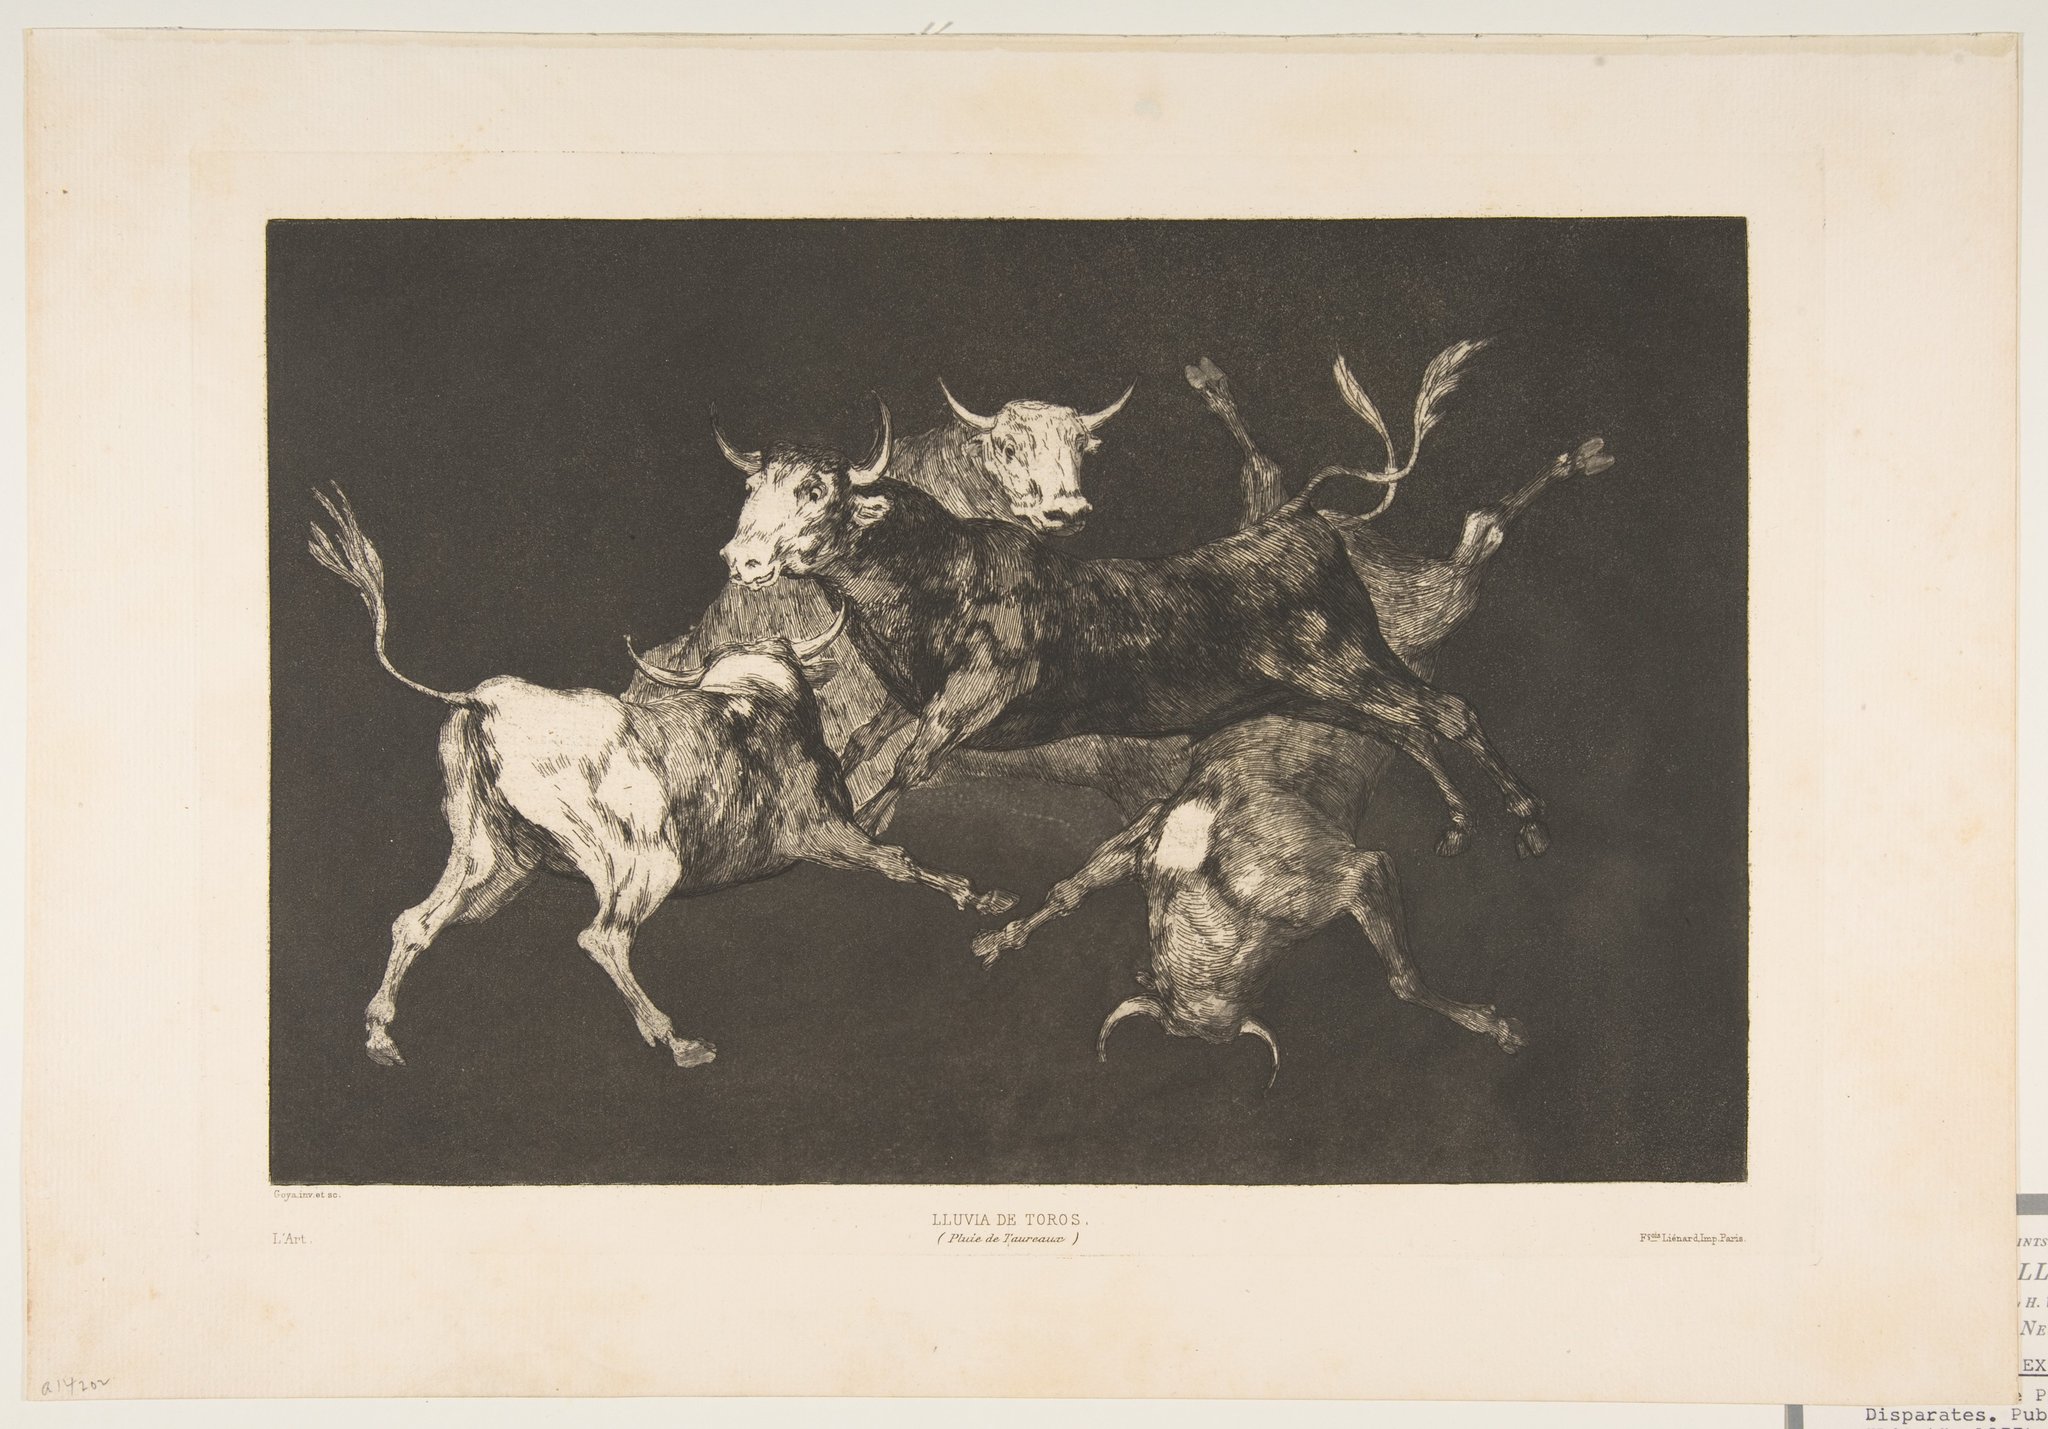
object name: print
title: Little Bulls' Folly, from "The Disparates" (Disparates, Plate D)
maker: goya (francisco de goya y lucientes)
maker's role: artist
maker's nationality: spanish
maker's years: 1746-1828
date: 1815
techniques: aquatint, drypoint, etching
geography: spain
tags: bulls